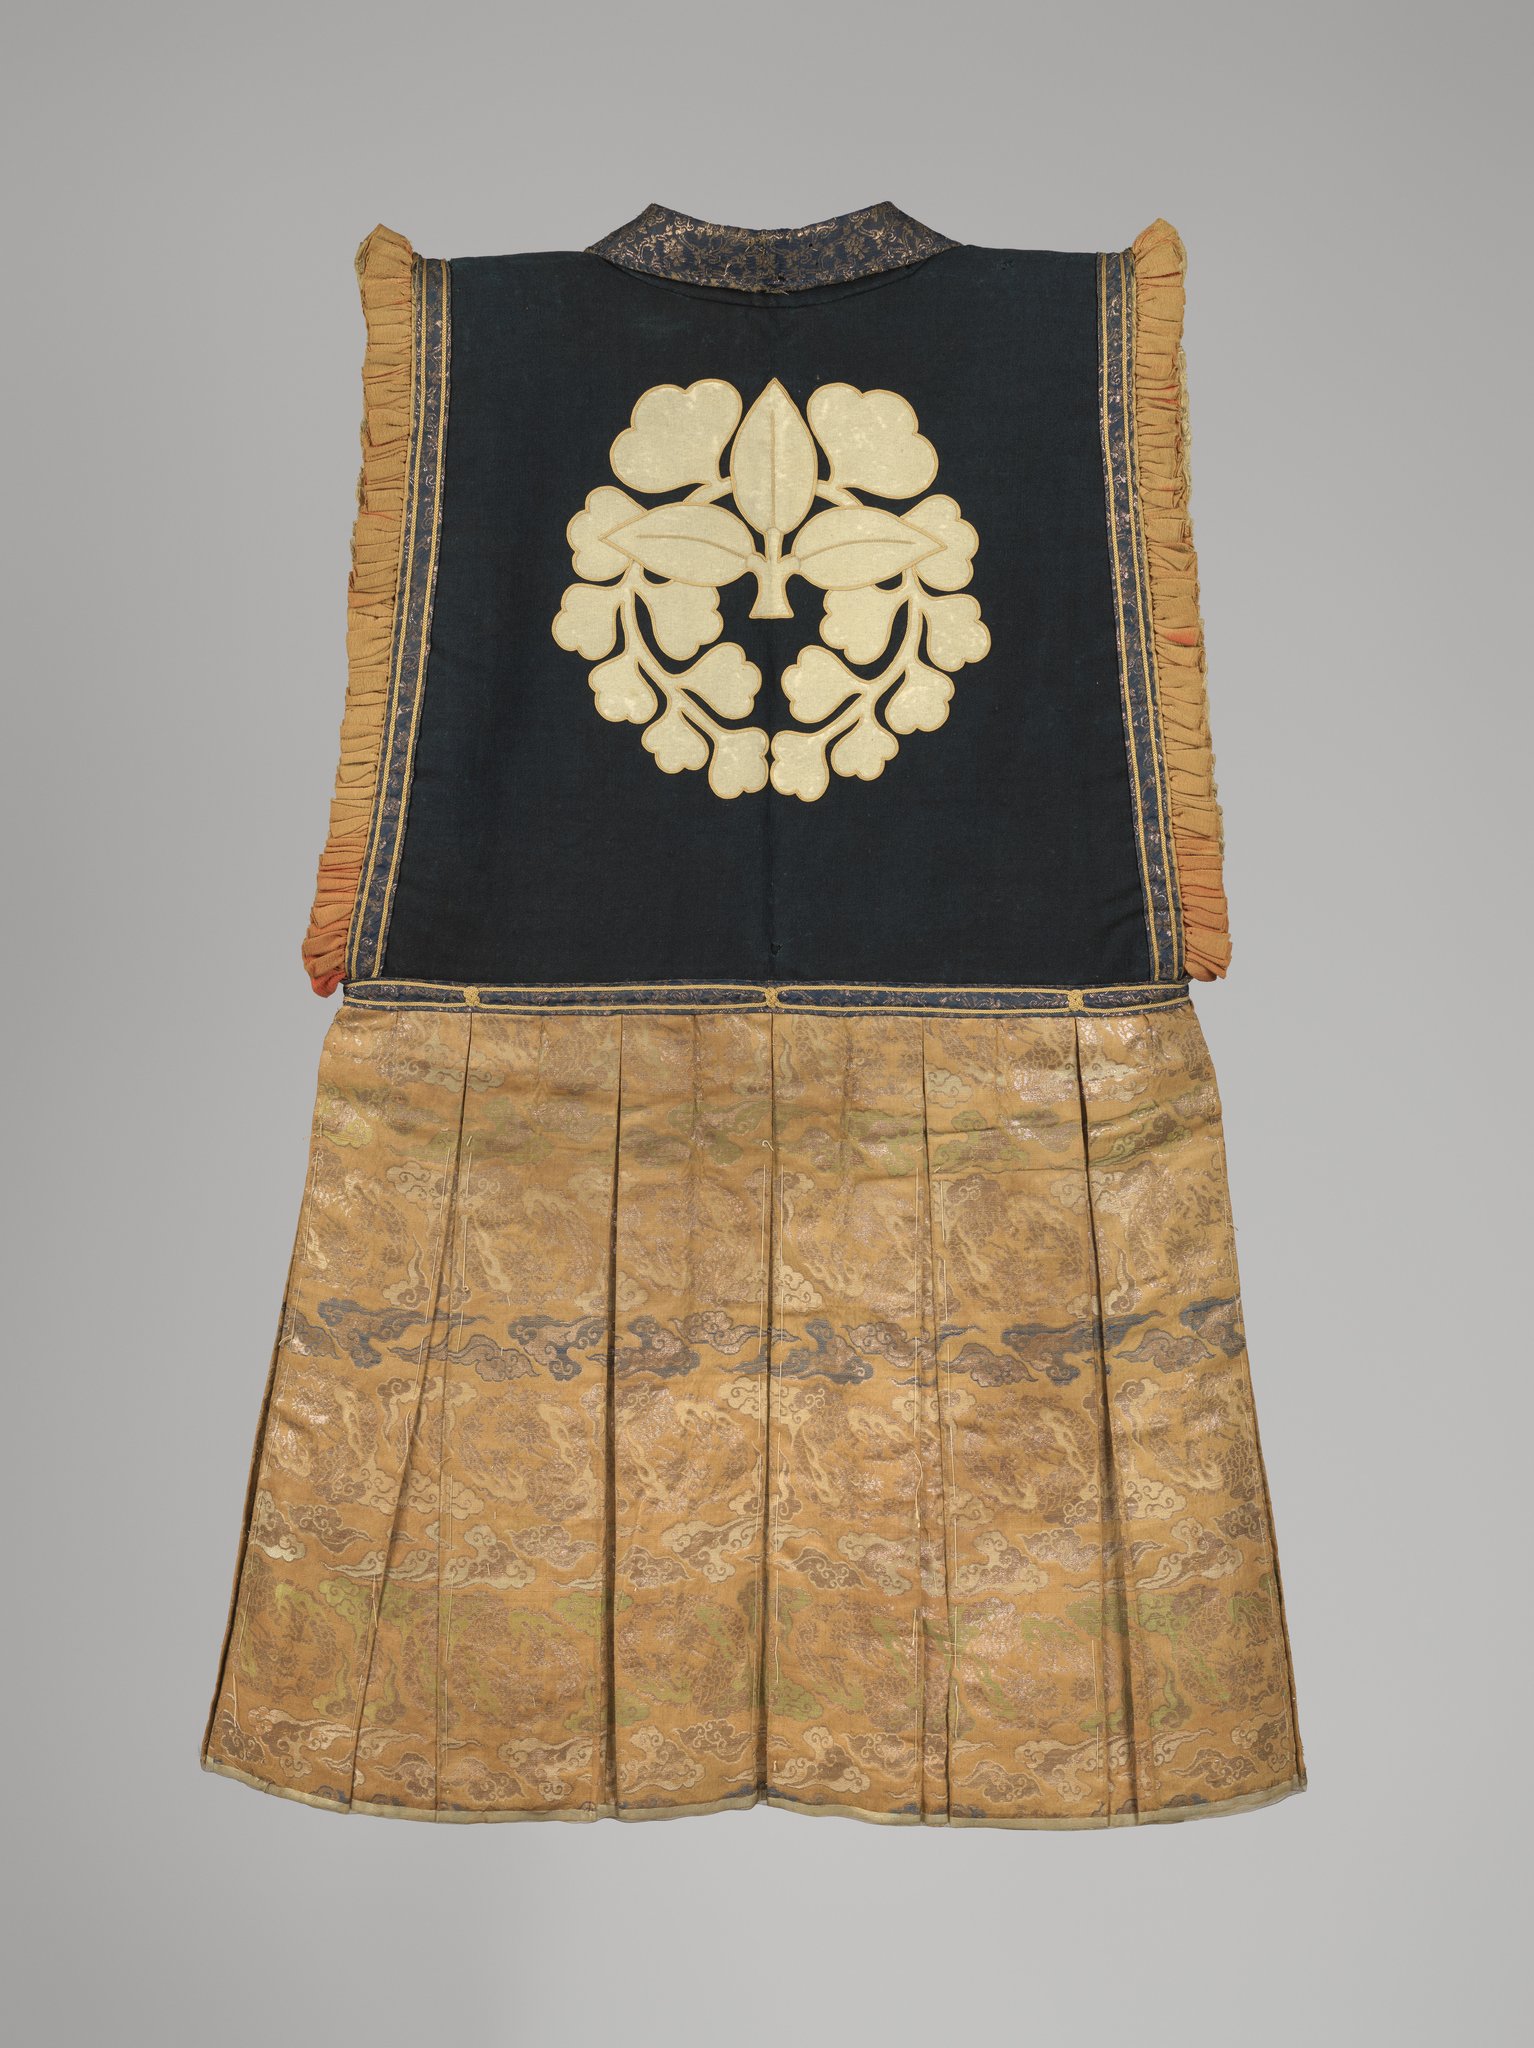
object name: battle surcoat jinbaori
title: Surcoat (jinbaori)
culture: japanese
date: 1567-1600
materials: felt, metal thread, silk, velvet, wool